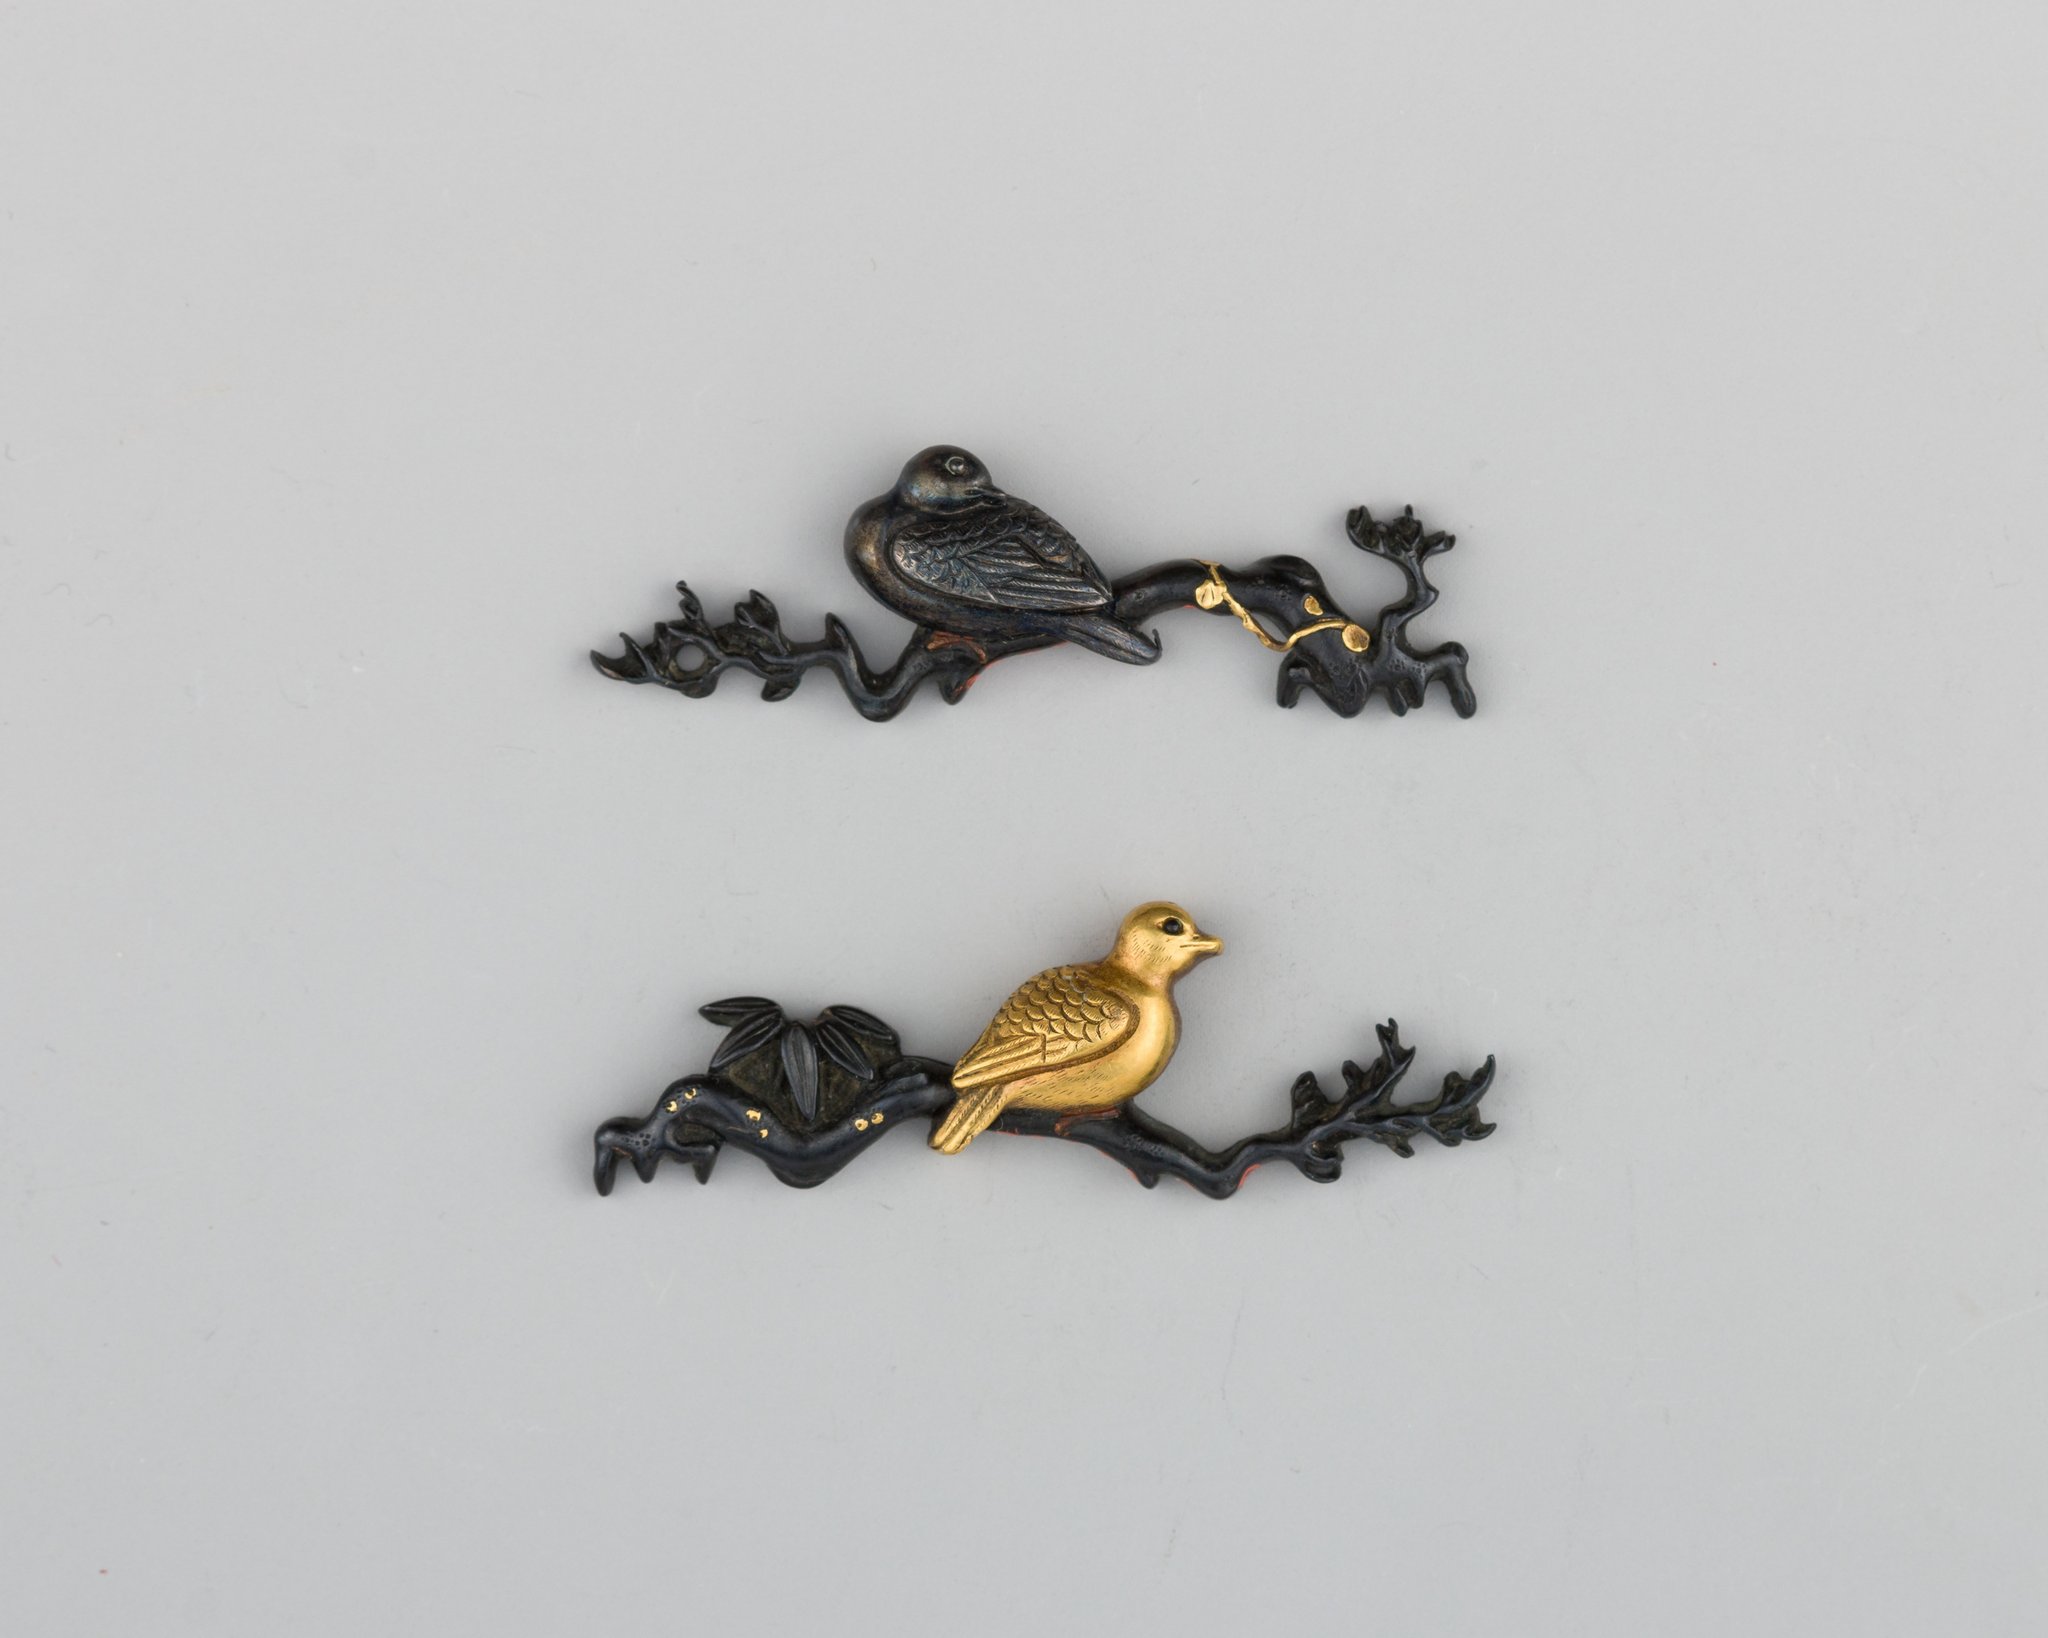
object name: pair of sword grip ornament menuki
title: Pair of Sword-Grip Ornaments (Menuki)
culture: japanese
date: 1701-1800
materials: copper, gold alloy, silver alloy, gold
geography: japan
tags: birds